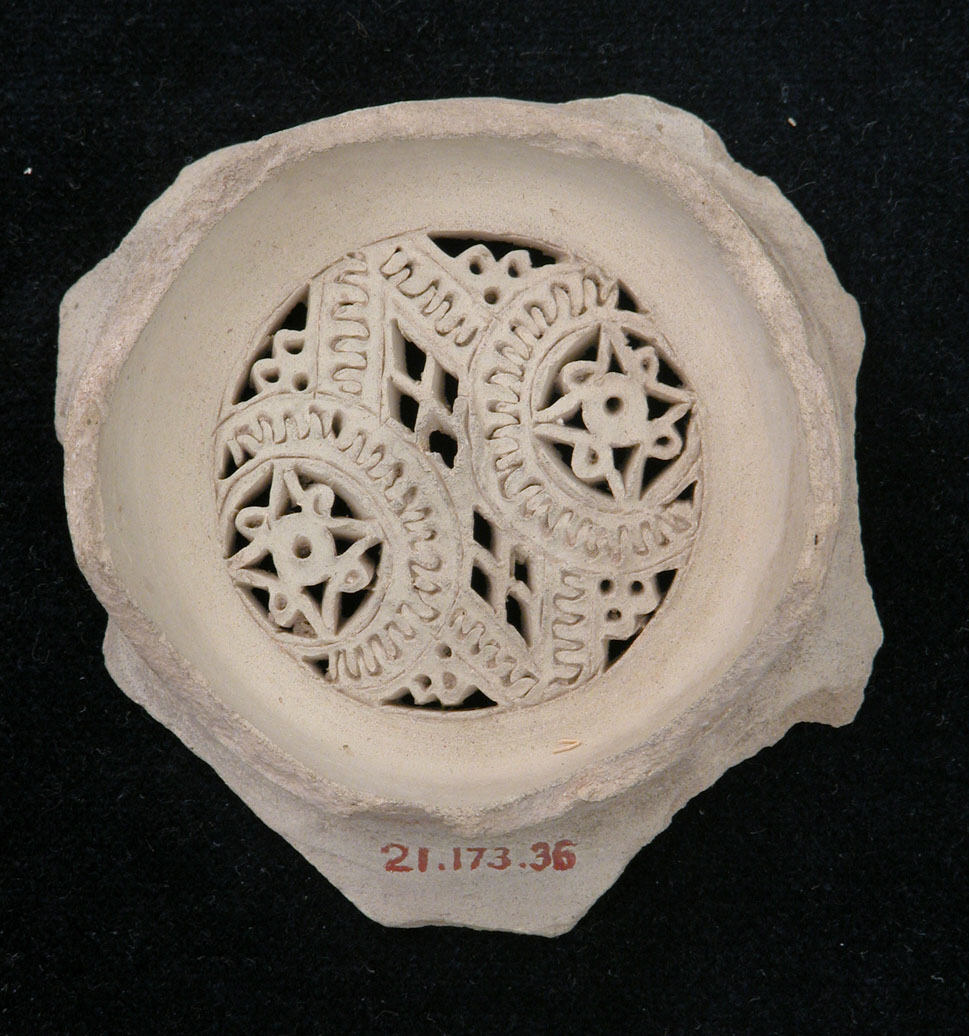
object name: water filter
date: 901-1200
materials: earthenware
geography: egypt